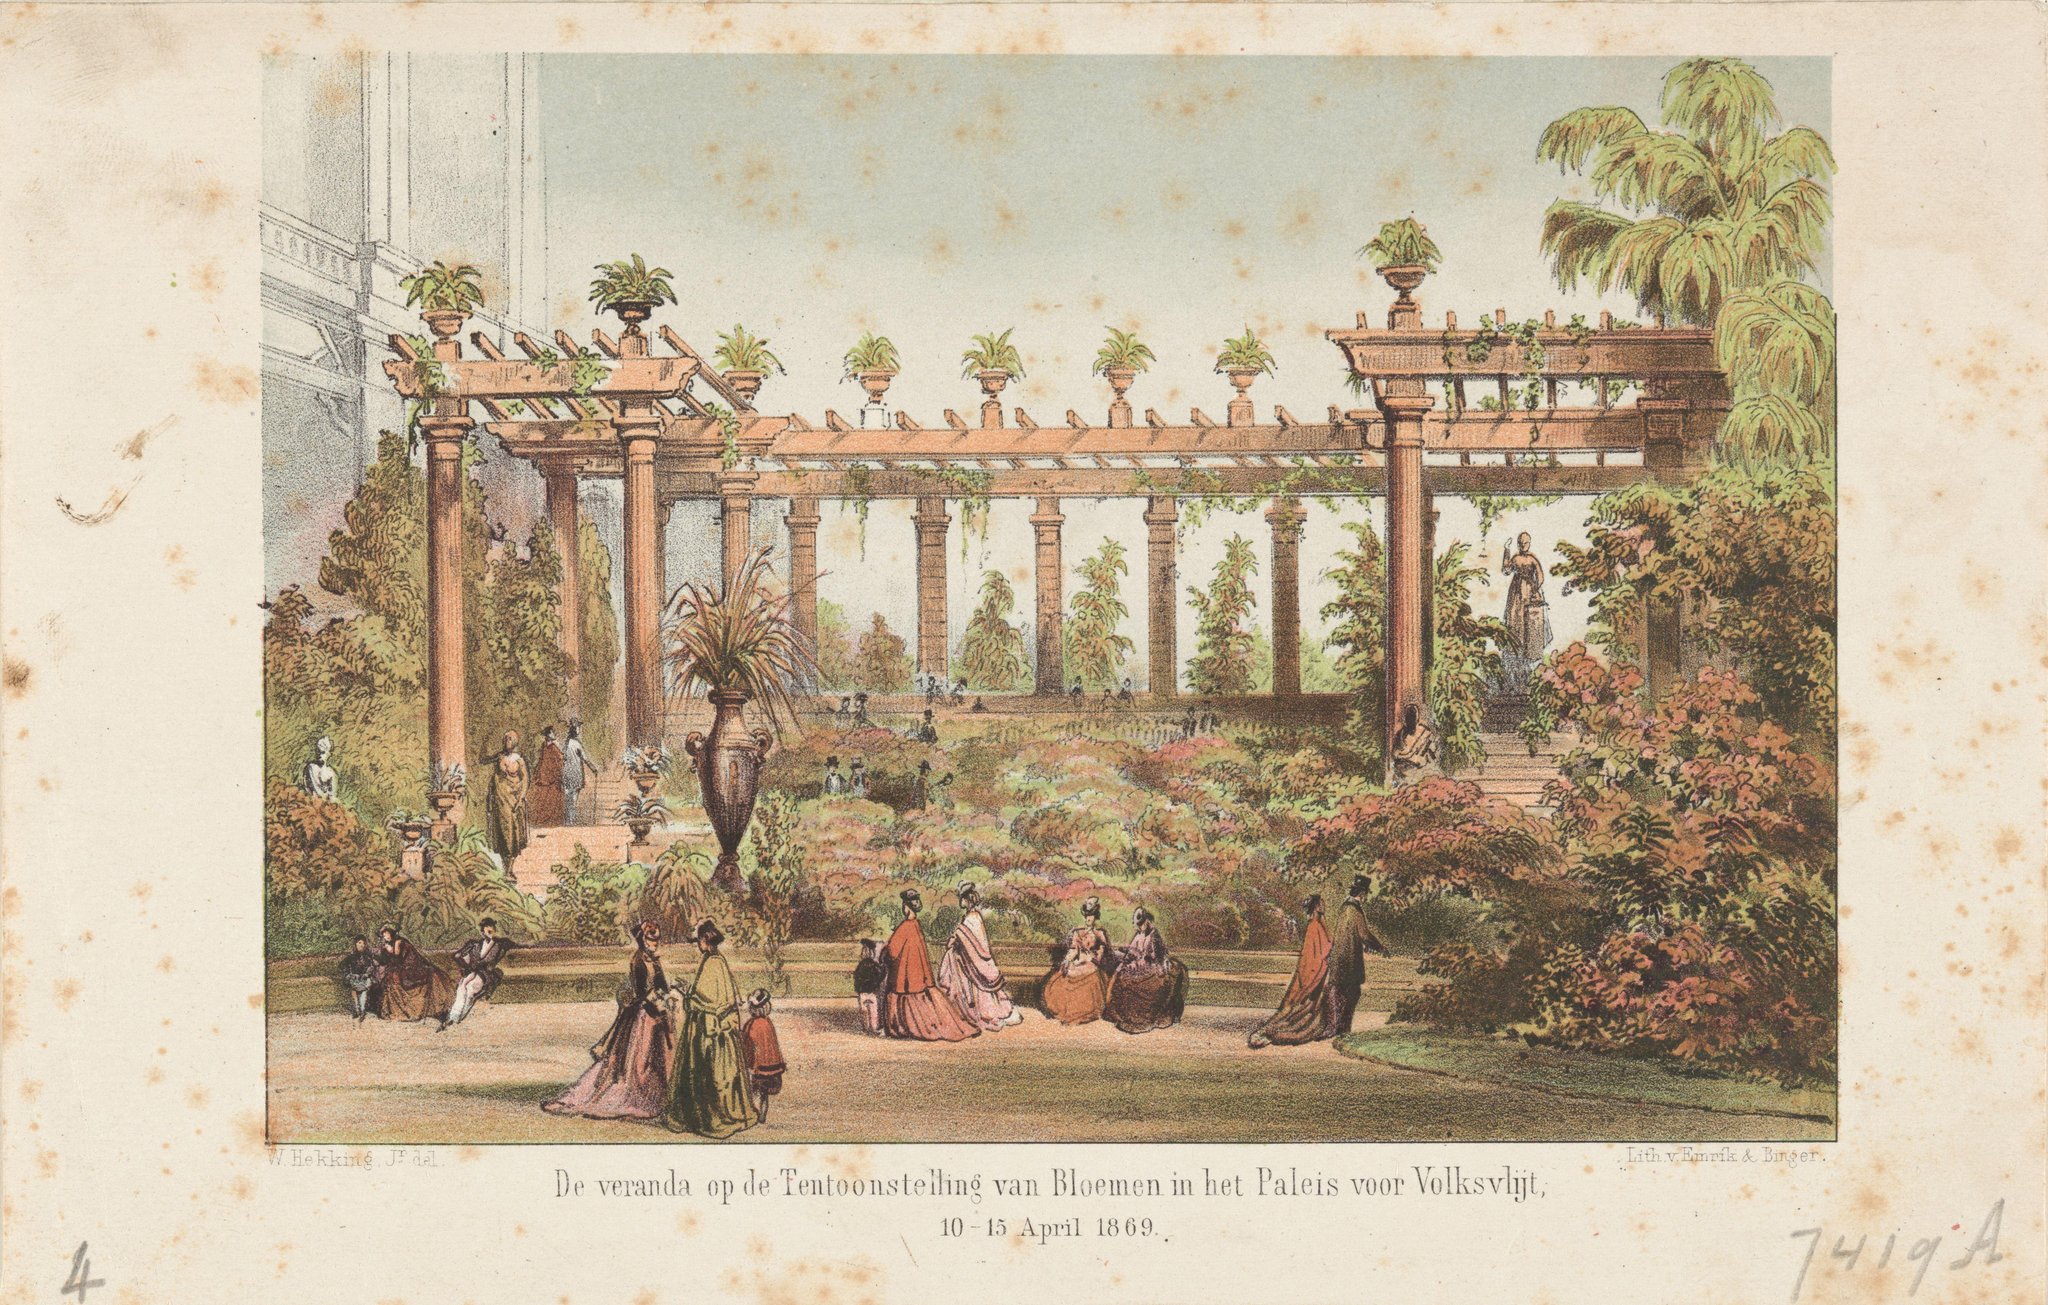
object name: print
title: De veranda op de Tentoonstelling van Bloemen in het Paleis voor Volksvlijt, 10-15 April 1869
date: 1869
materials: paper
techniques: lithograph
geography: netherlands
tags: flowers, flower culture, (annual) fair, trade fair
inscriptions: collector's mark: Lugt 2228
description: Tentoonstelling van bloemen in het Paleis voor Volksvlijt te Amsterdam, 10-15 april 1869.